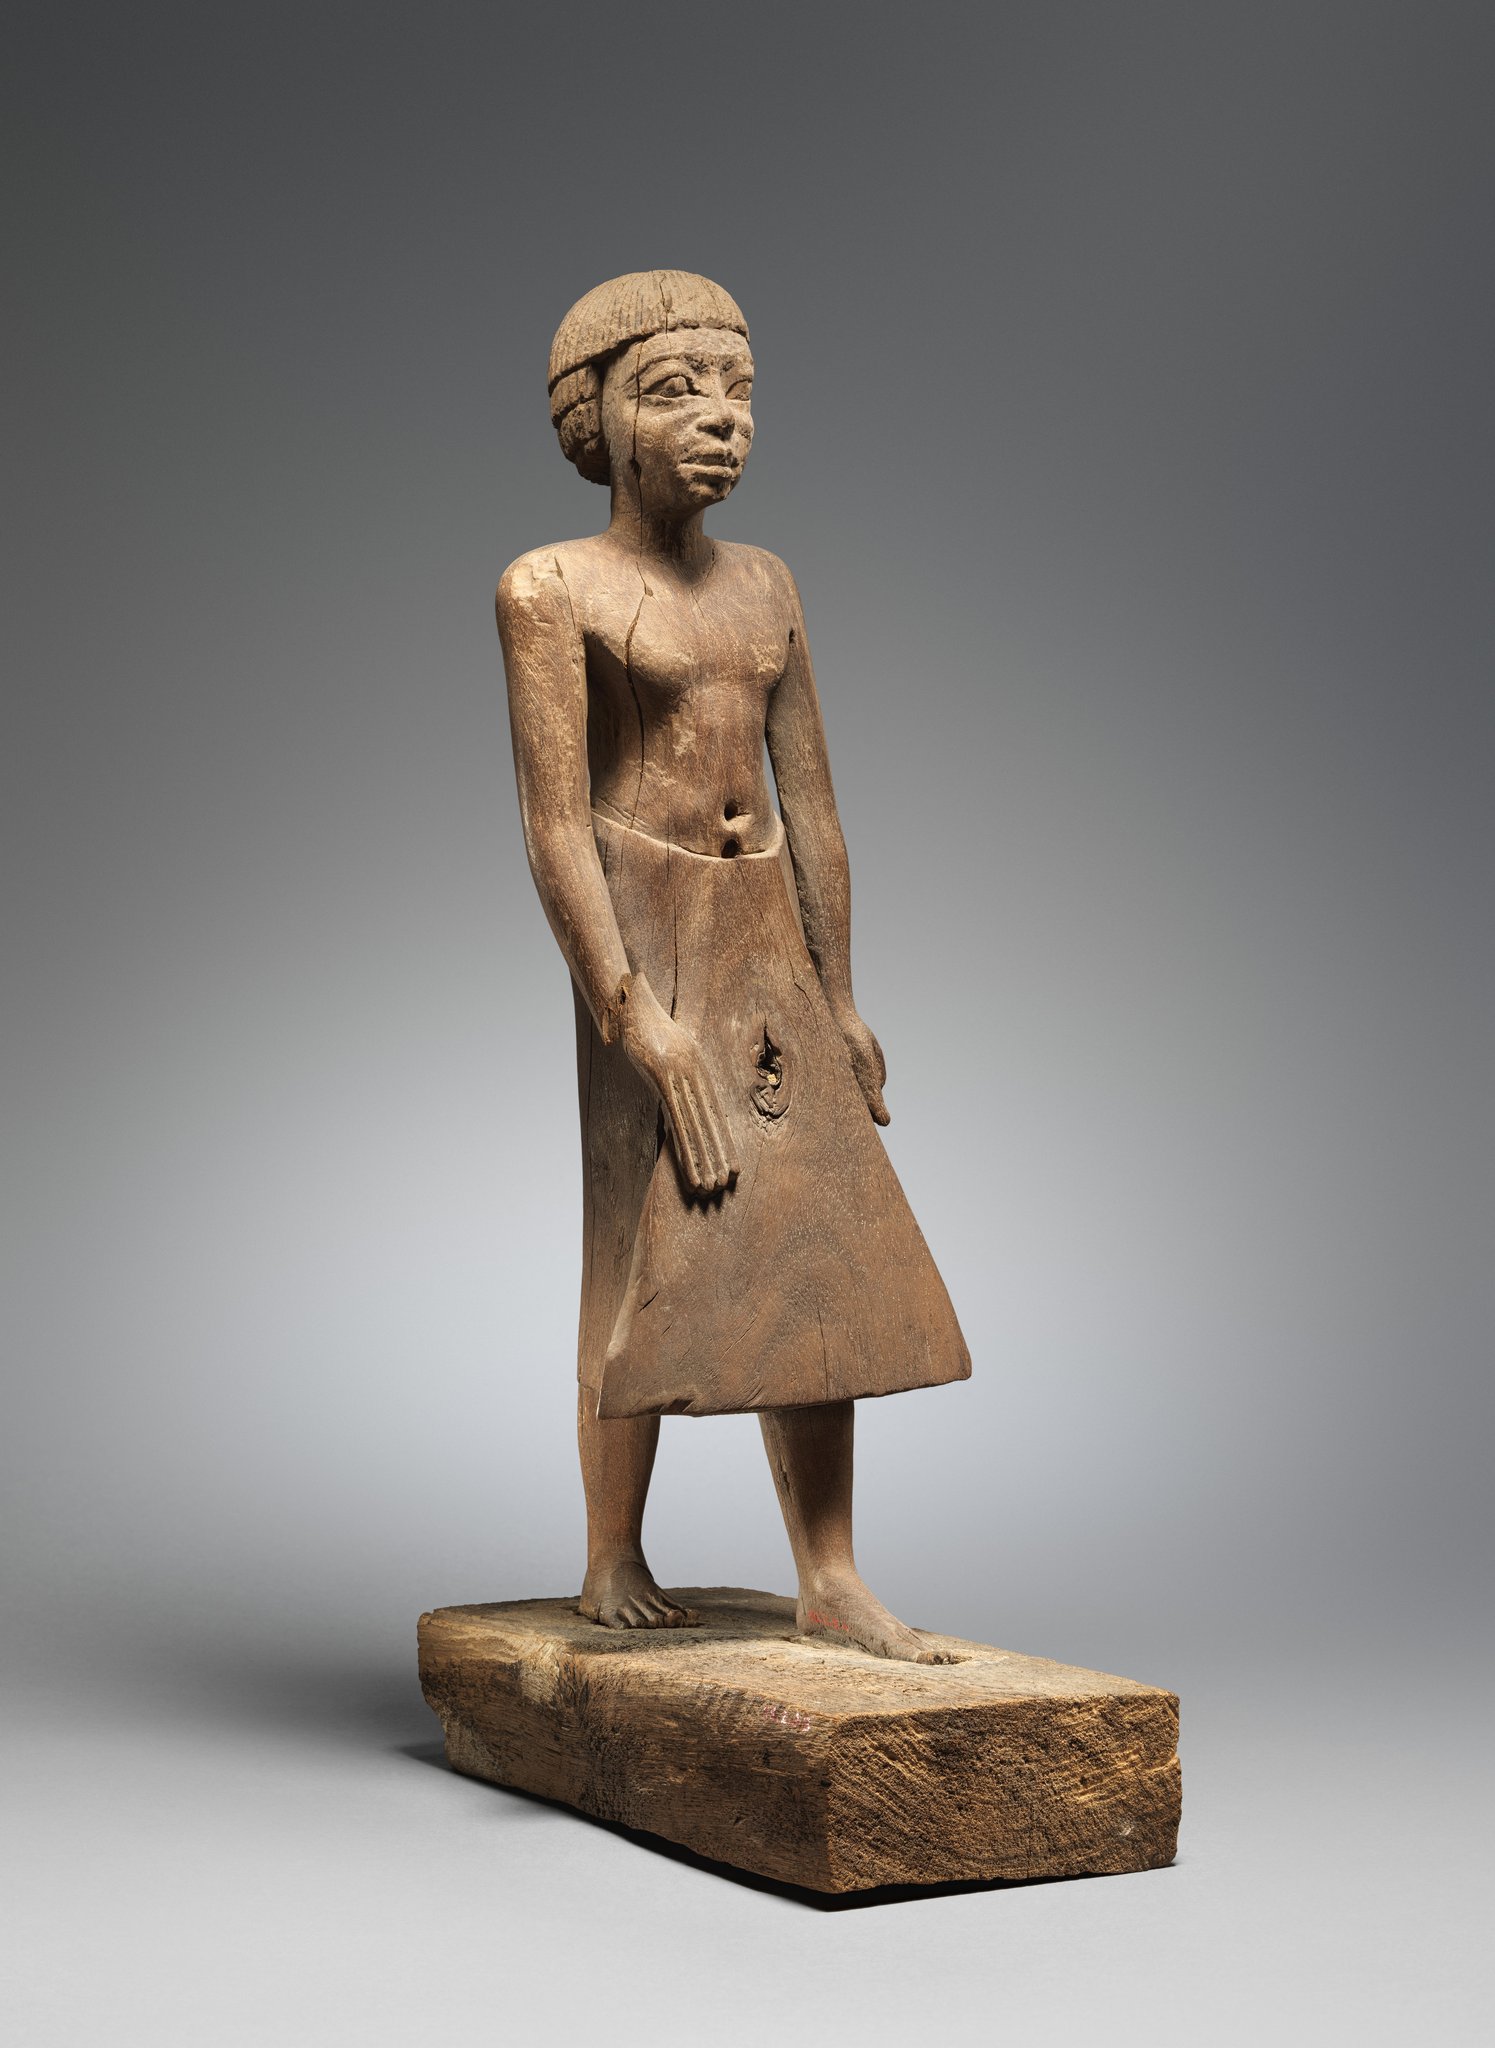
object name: statue, tjeteti, middle age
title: Statue of Tjeteti in middle age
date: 2200-2152 BCE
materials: wood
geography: egypt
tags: men